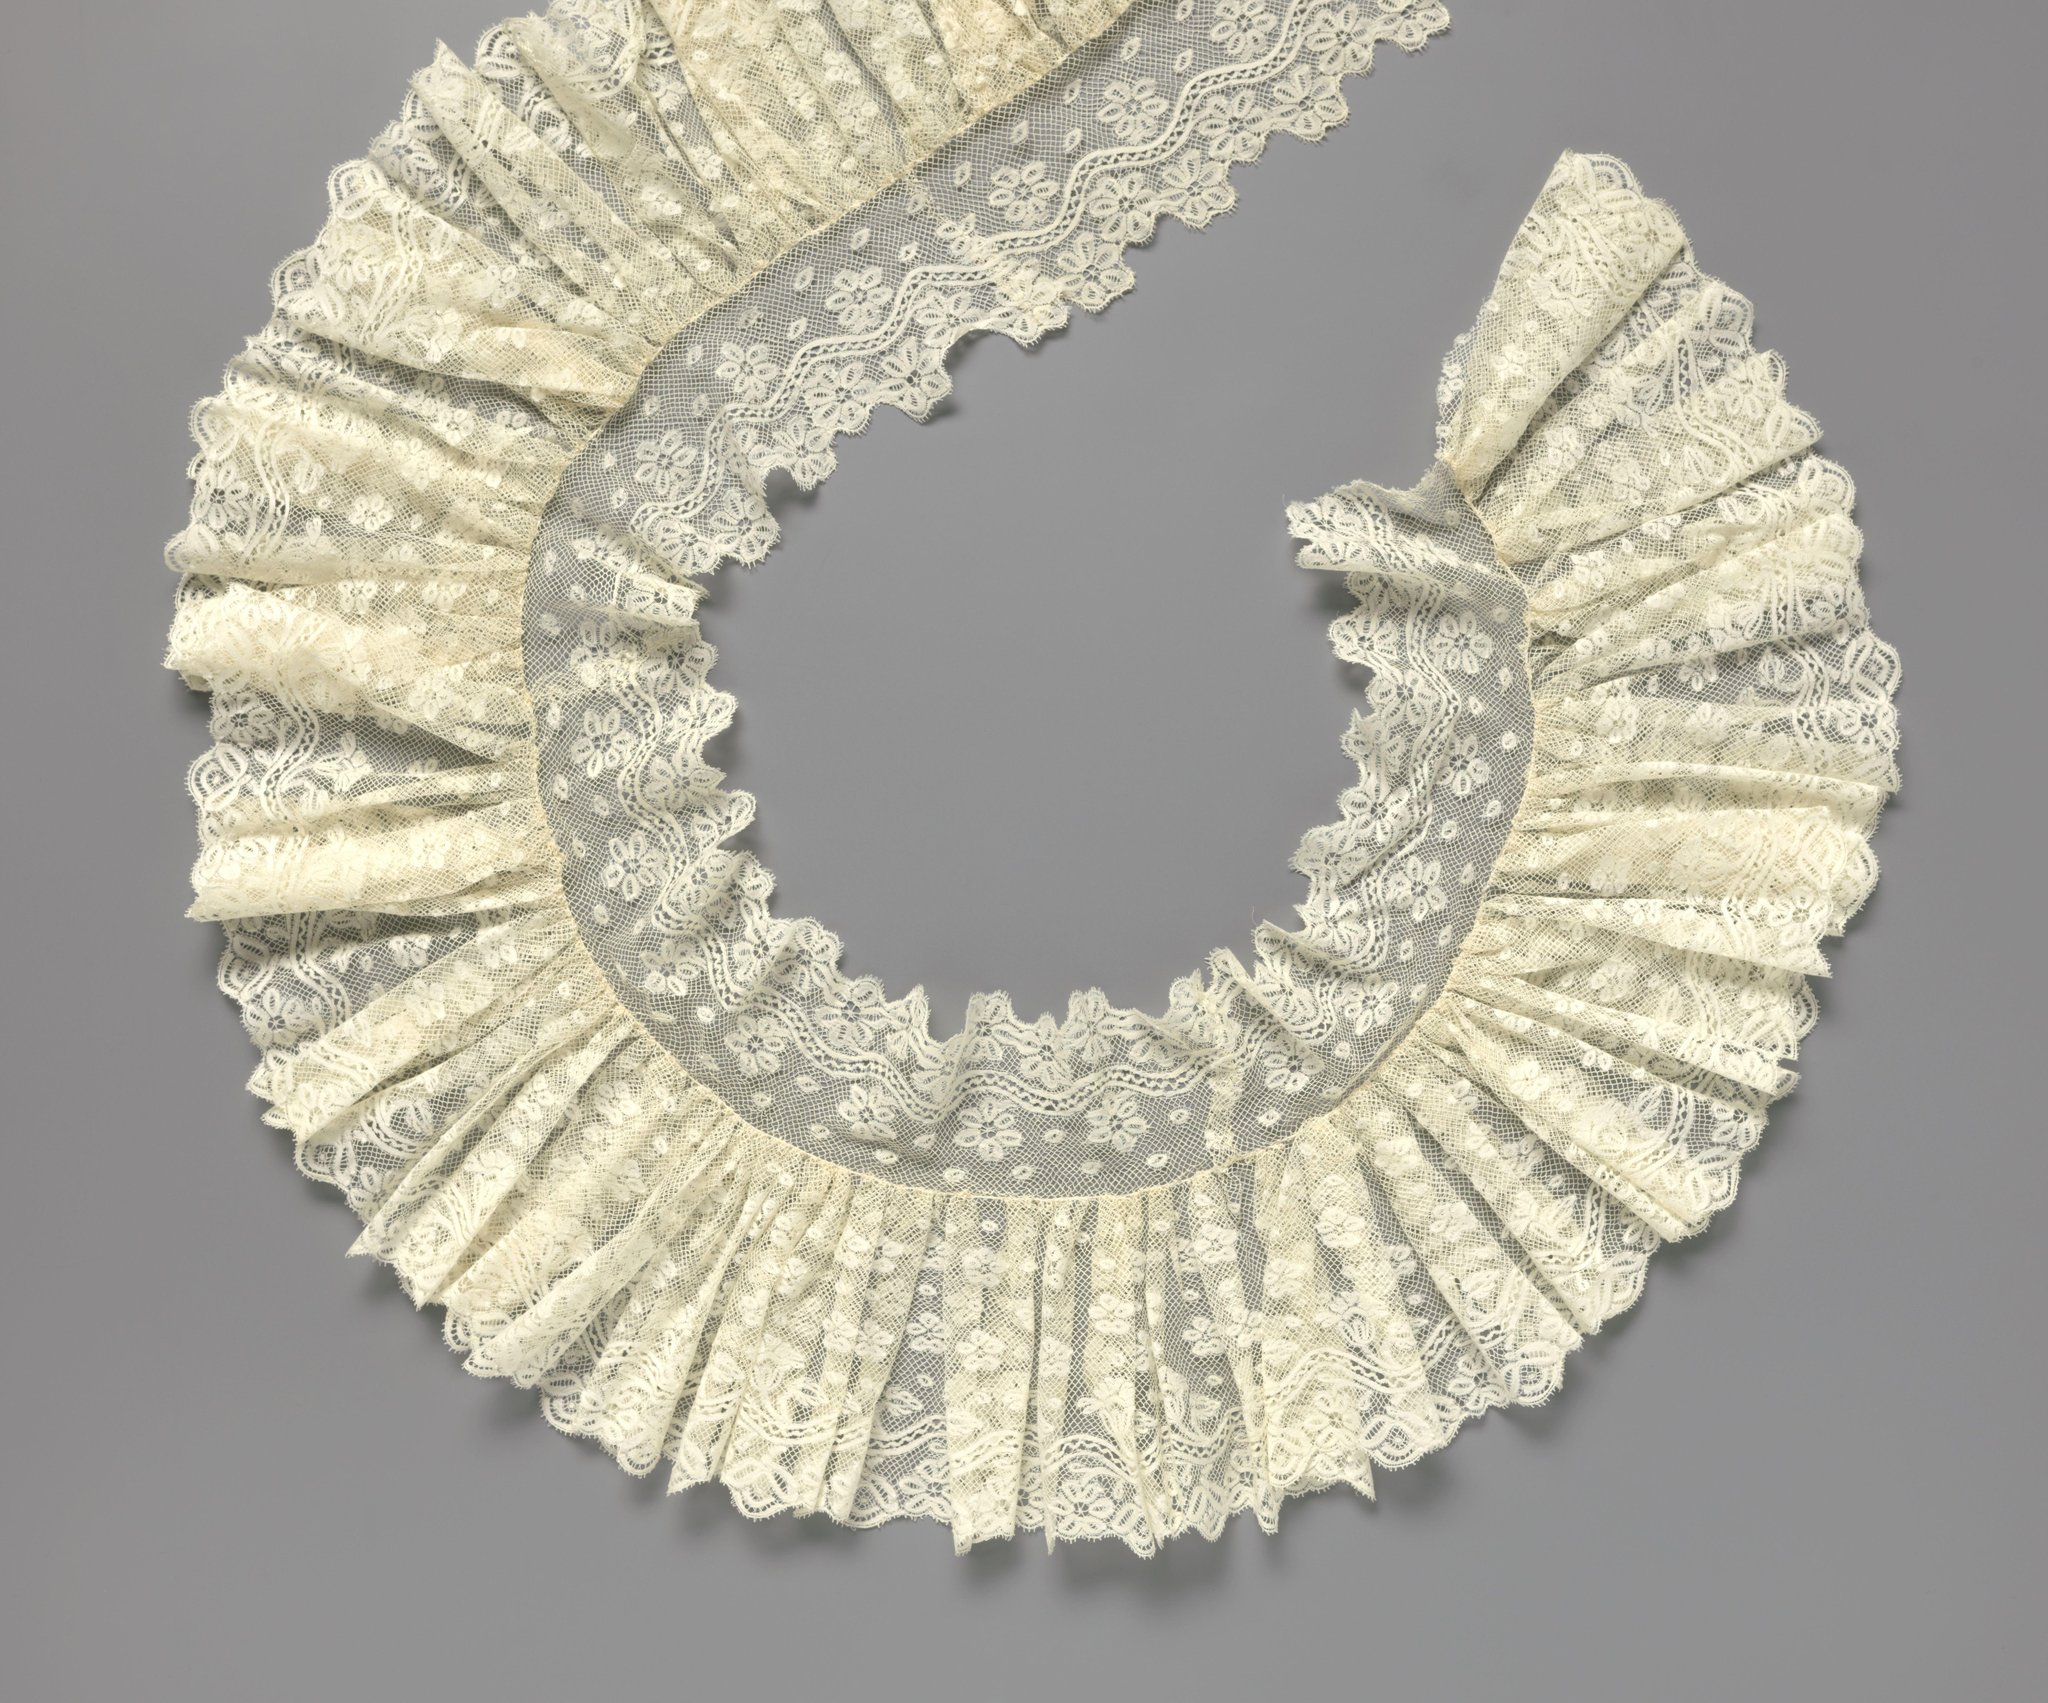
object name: strip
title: Strook kloskant met golvende lijn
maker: Anonymous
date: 1870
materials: linen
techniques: lace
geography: sluis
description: Strook naturelkleurige kloskant: Valenciennes-kant. Op een traliegrond, een vierkante Valenciennes-grond, staan gestrooide stengelloze margrietjes tussen pailletten. Langs de rand loopt een golvende lijst met zigzag-lijn, aan weerszijden waarvan eenzijdig gerichte stengels met kelkbloempjes. De motieven zijn gemaakt in linnenslag met opengewerkte randjes en uitsparingen. Overstekende paren zorgen voor een versierend effect en in bloemharten staat een sneeuwvlok. De strook is gerimpeld aan een smallere strook met stengelloze margrietjes genaaid.